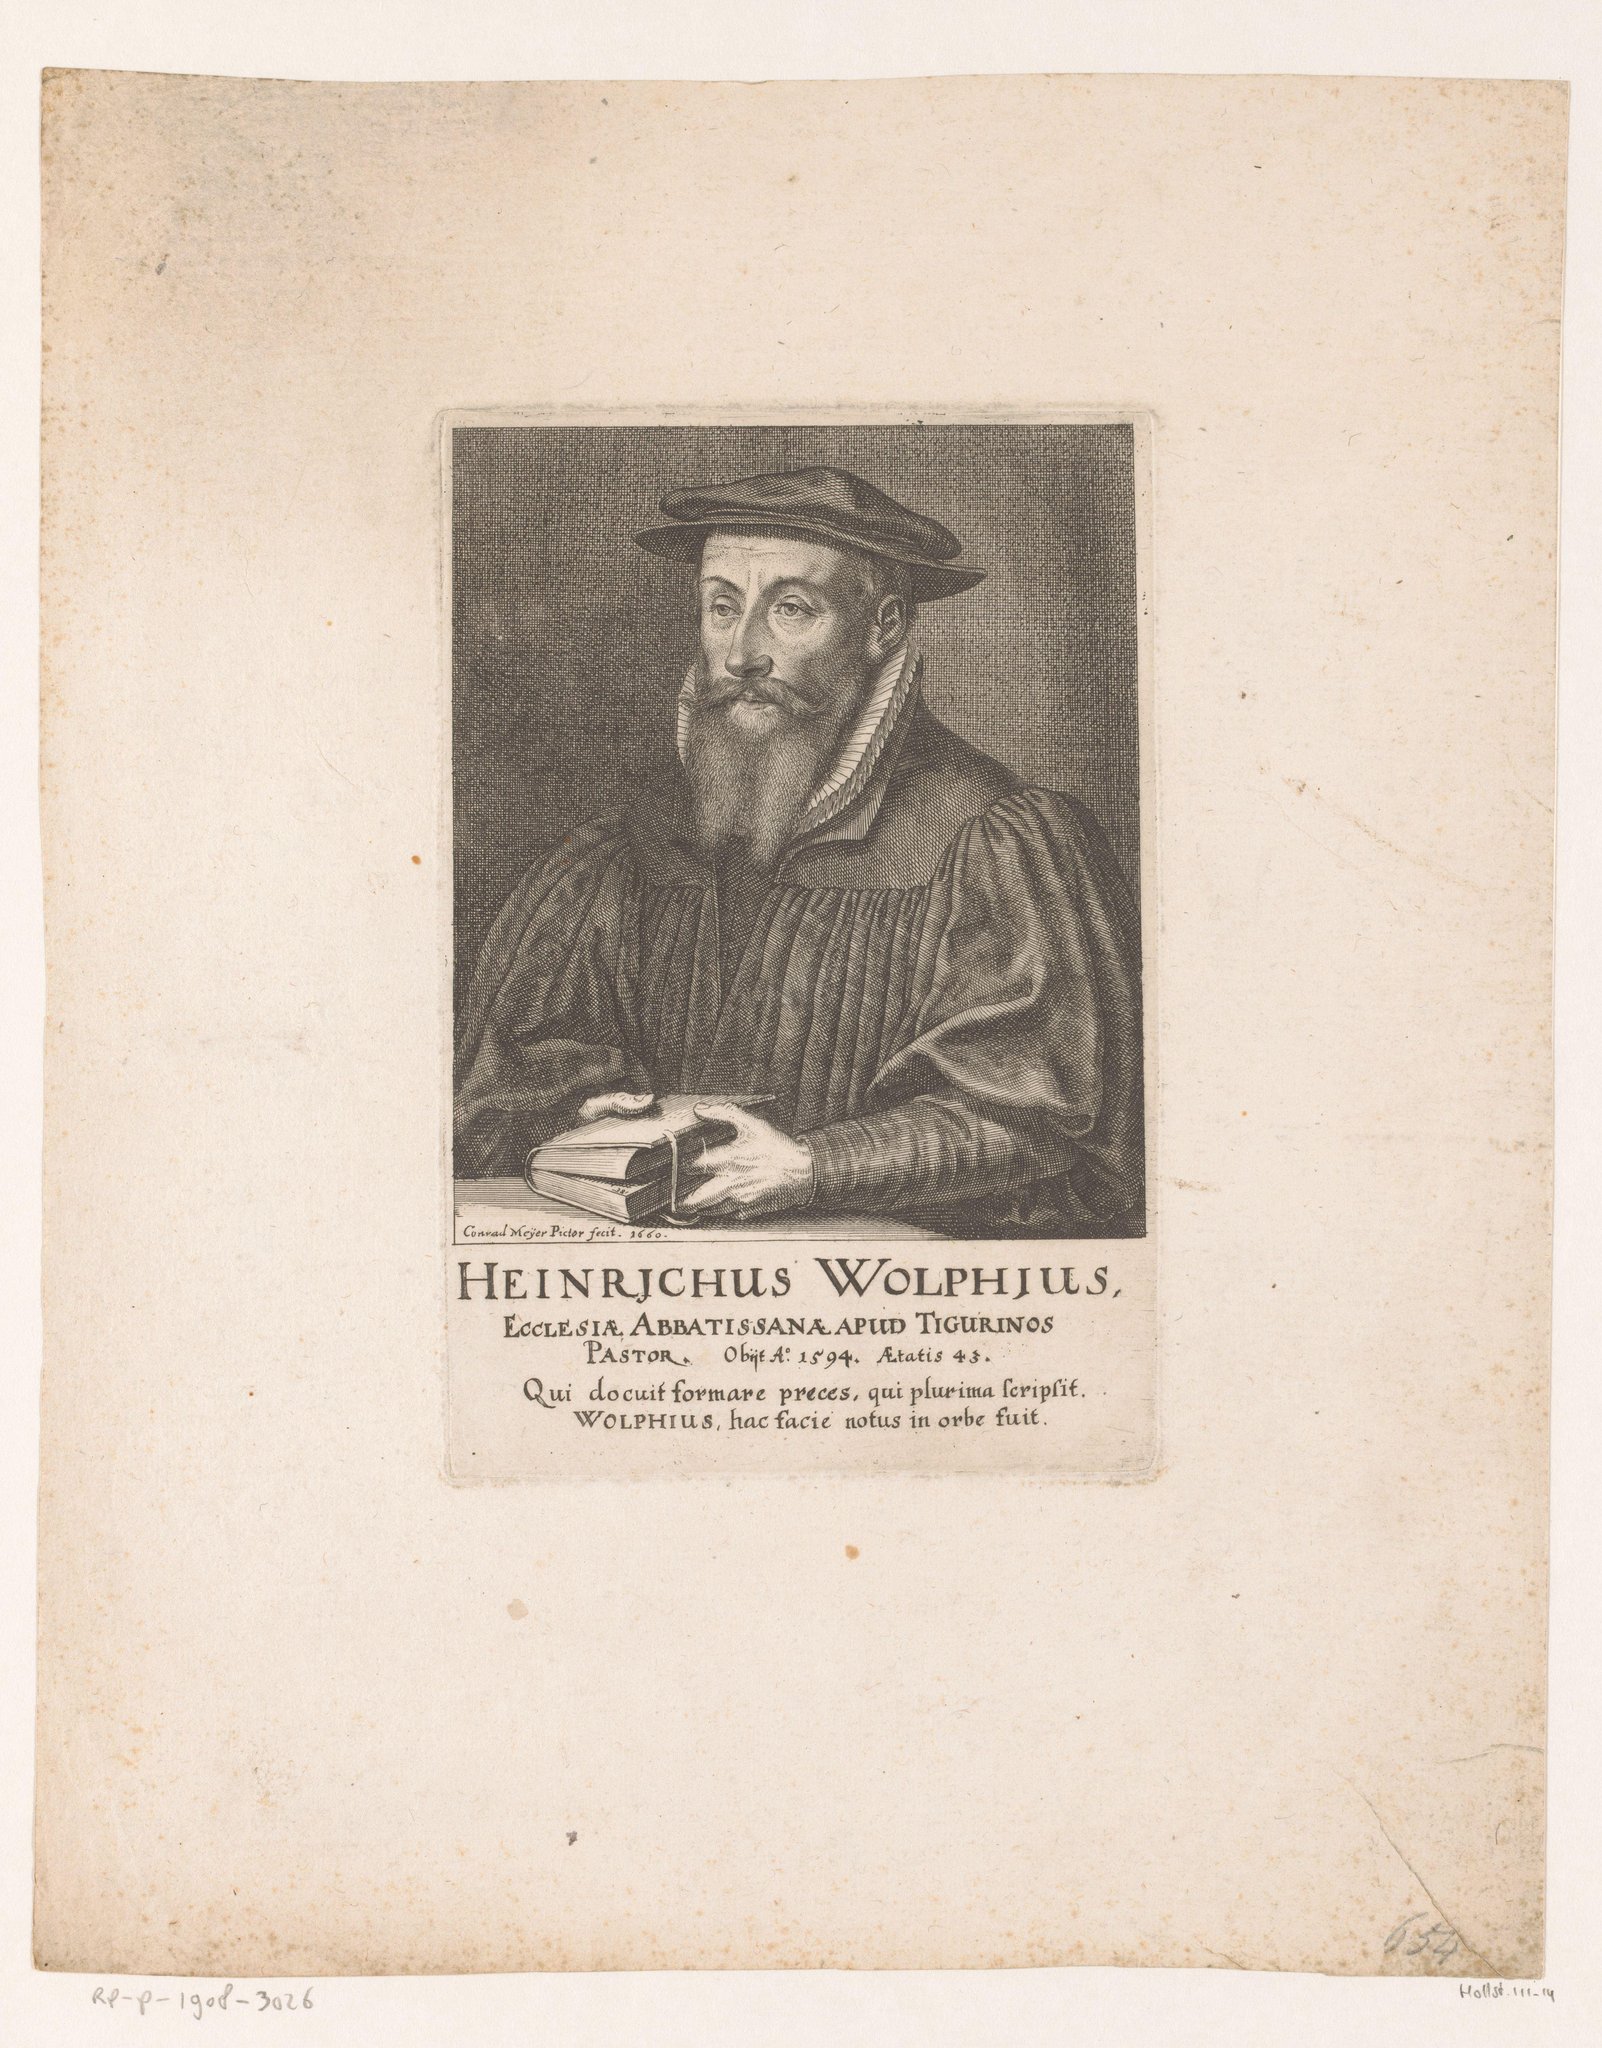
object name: print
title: Portret van Heinrich Wolf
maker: conrad meyer (i)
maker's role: painter, print maker, publisher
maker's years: 1618-1689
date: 1628-1689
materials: paper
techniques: engraving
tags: theologian, historical persons, book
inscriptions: collector's mark: Lugt 2228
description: Onderdeel van een serie van 62 portretten van priesters en theologen van Zürich. Zie Hollstein German 111, 1-41.